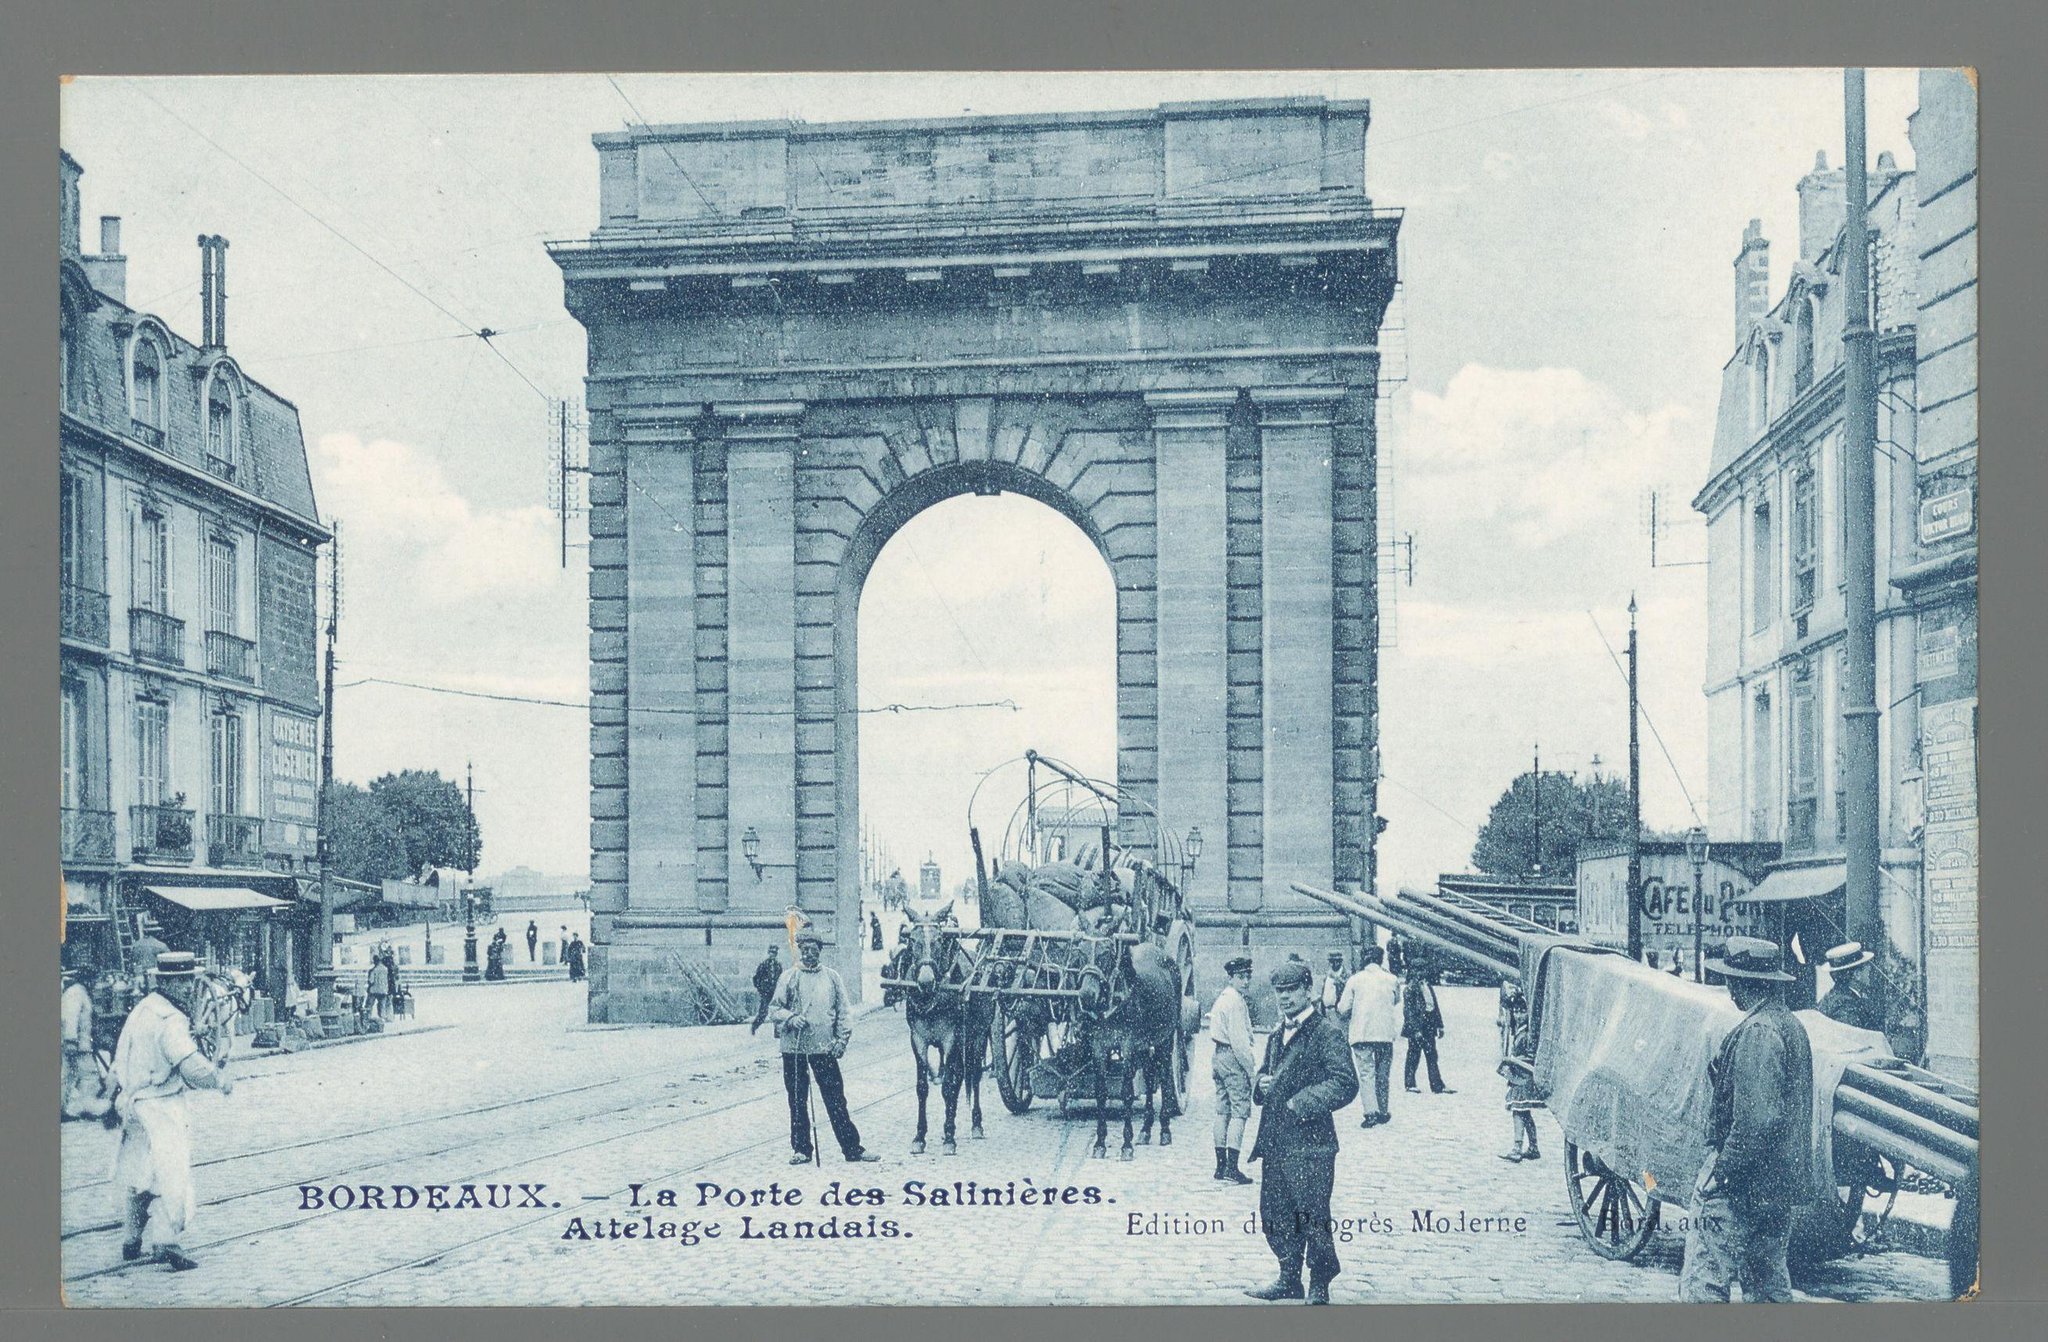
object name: photomechanical print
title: Bordeaux. La Porte des Salinières. Attelage Landais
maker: Anonymous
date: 1903-1920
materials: cardboard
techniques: photograph, writing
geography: bordeaux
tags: two-wheeled, animal-drawn vehicle, city-gate, city-view, and landscape with man-made constructions (+ city(-scape) with figures, staffage)